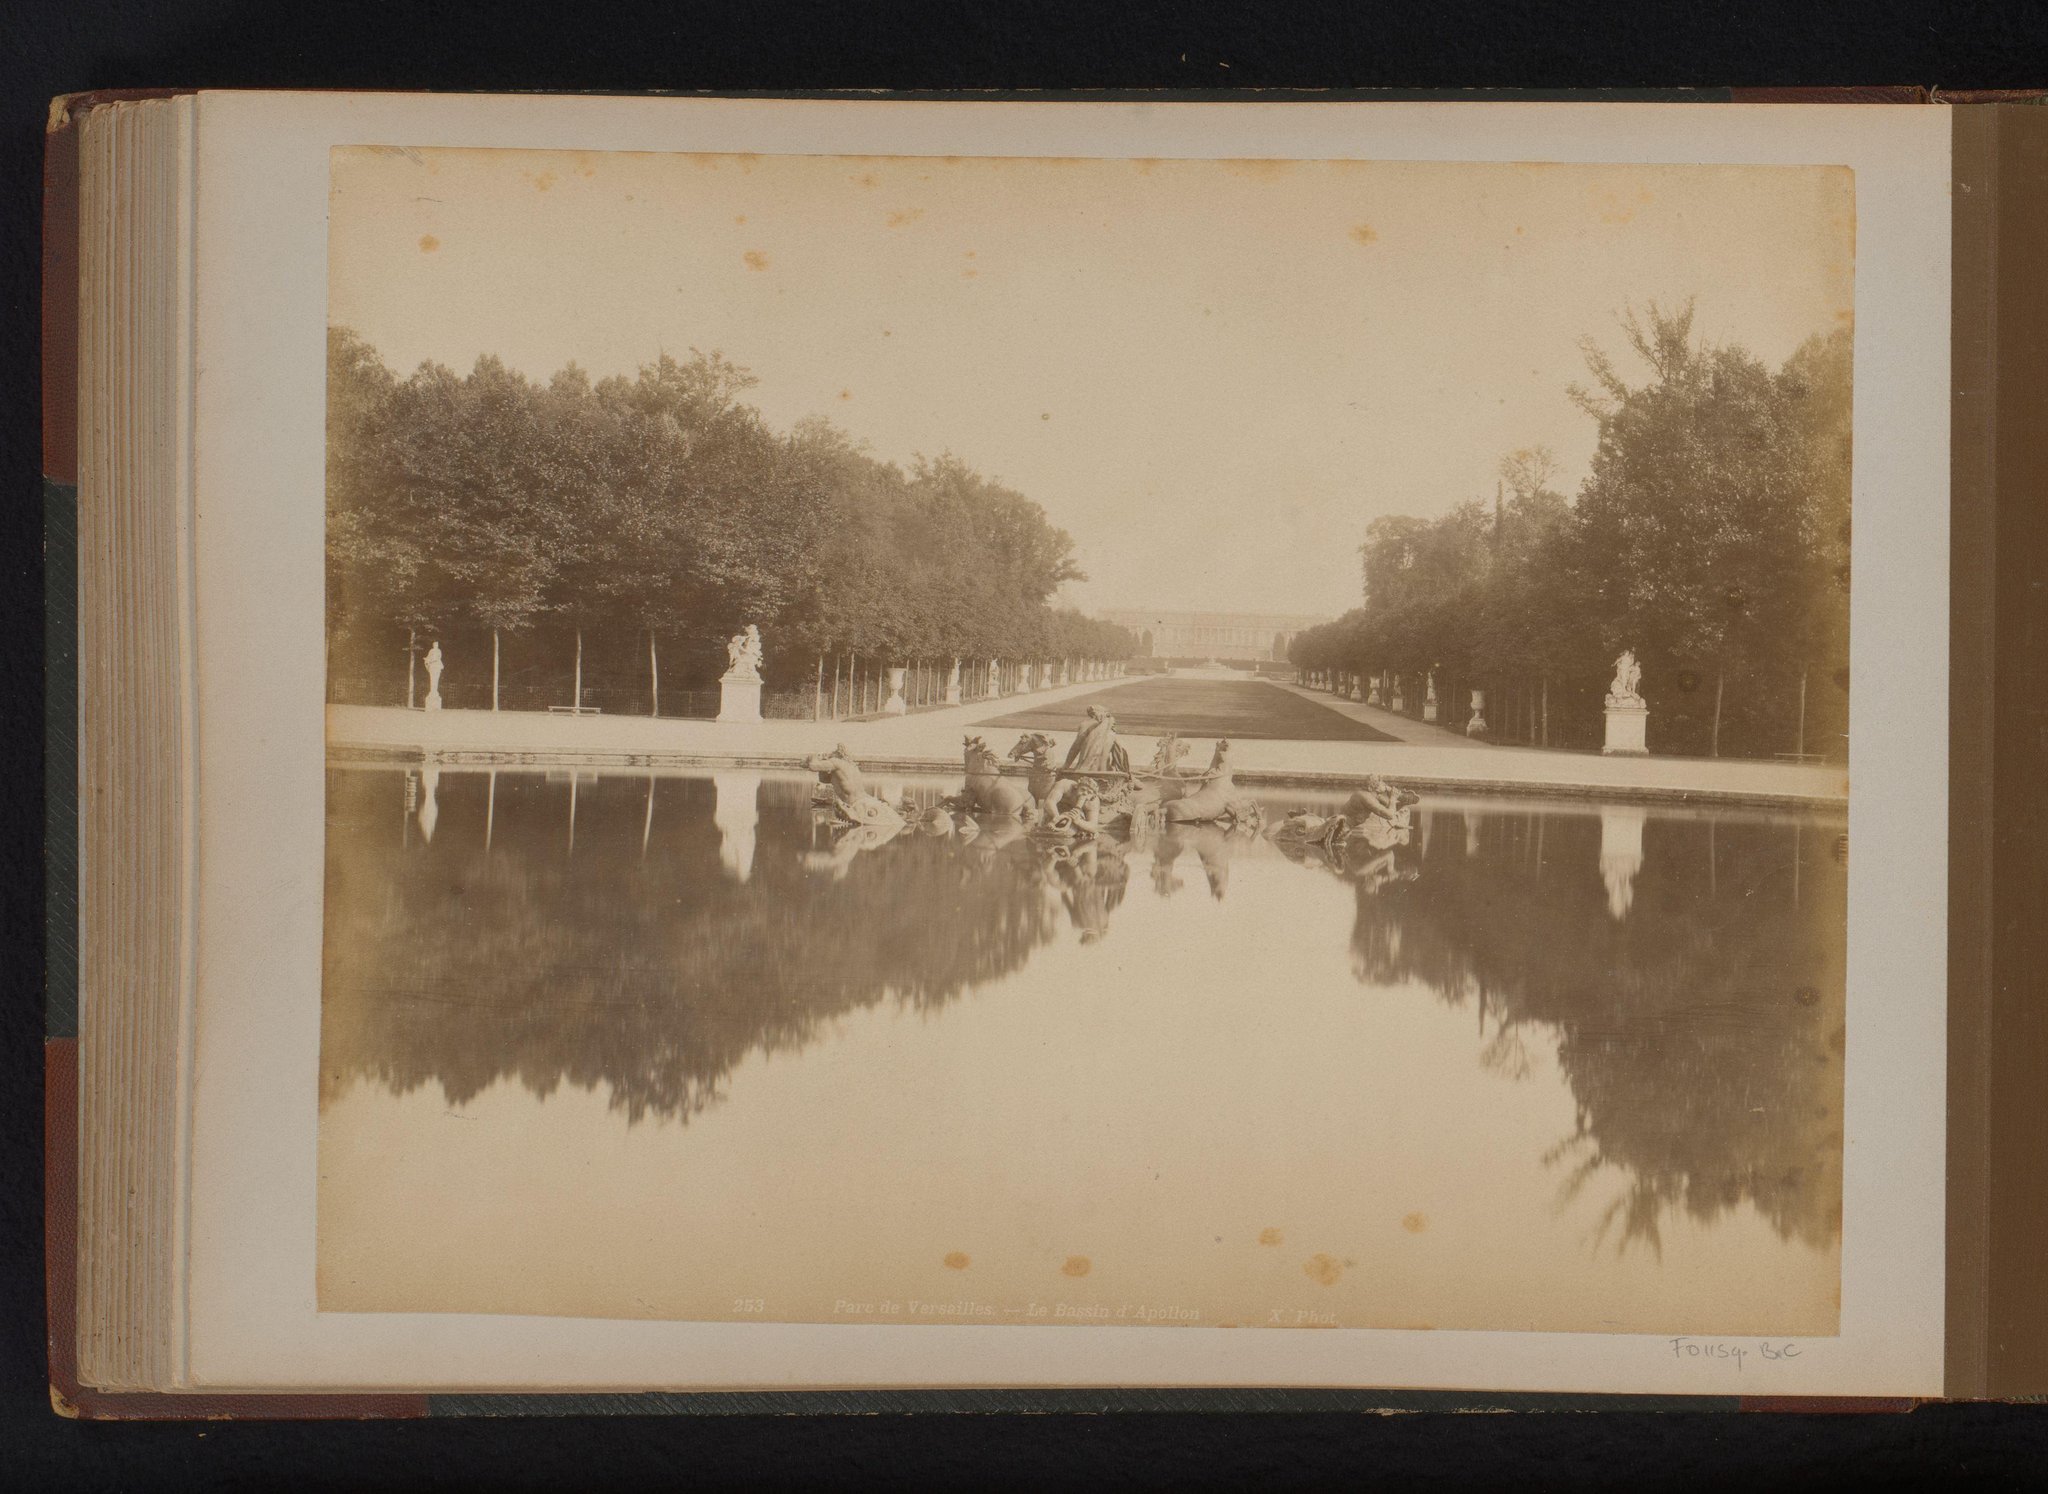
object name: photograph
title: Bassin d'Apollon in de tuin van het Paleis van Versailles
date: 1870-1890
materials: photographic support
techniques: albumen print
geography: versailles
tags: garden fountain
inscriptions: number: ‘253’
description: Onderdeel van Reisalbum met opnames van bezienswaardigheden in Zweden, Noorwegen, Denemarken, Beieren, Milaan en Parijs.